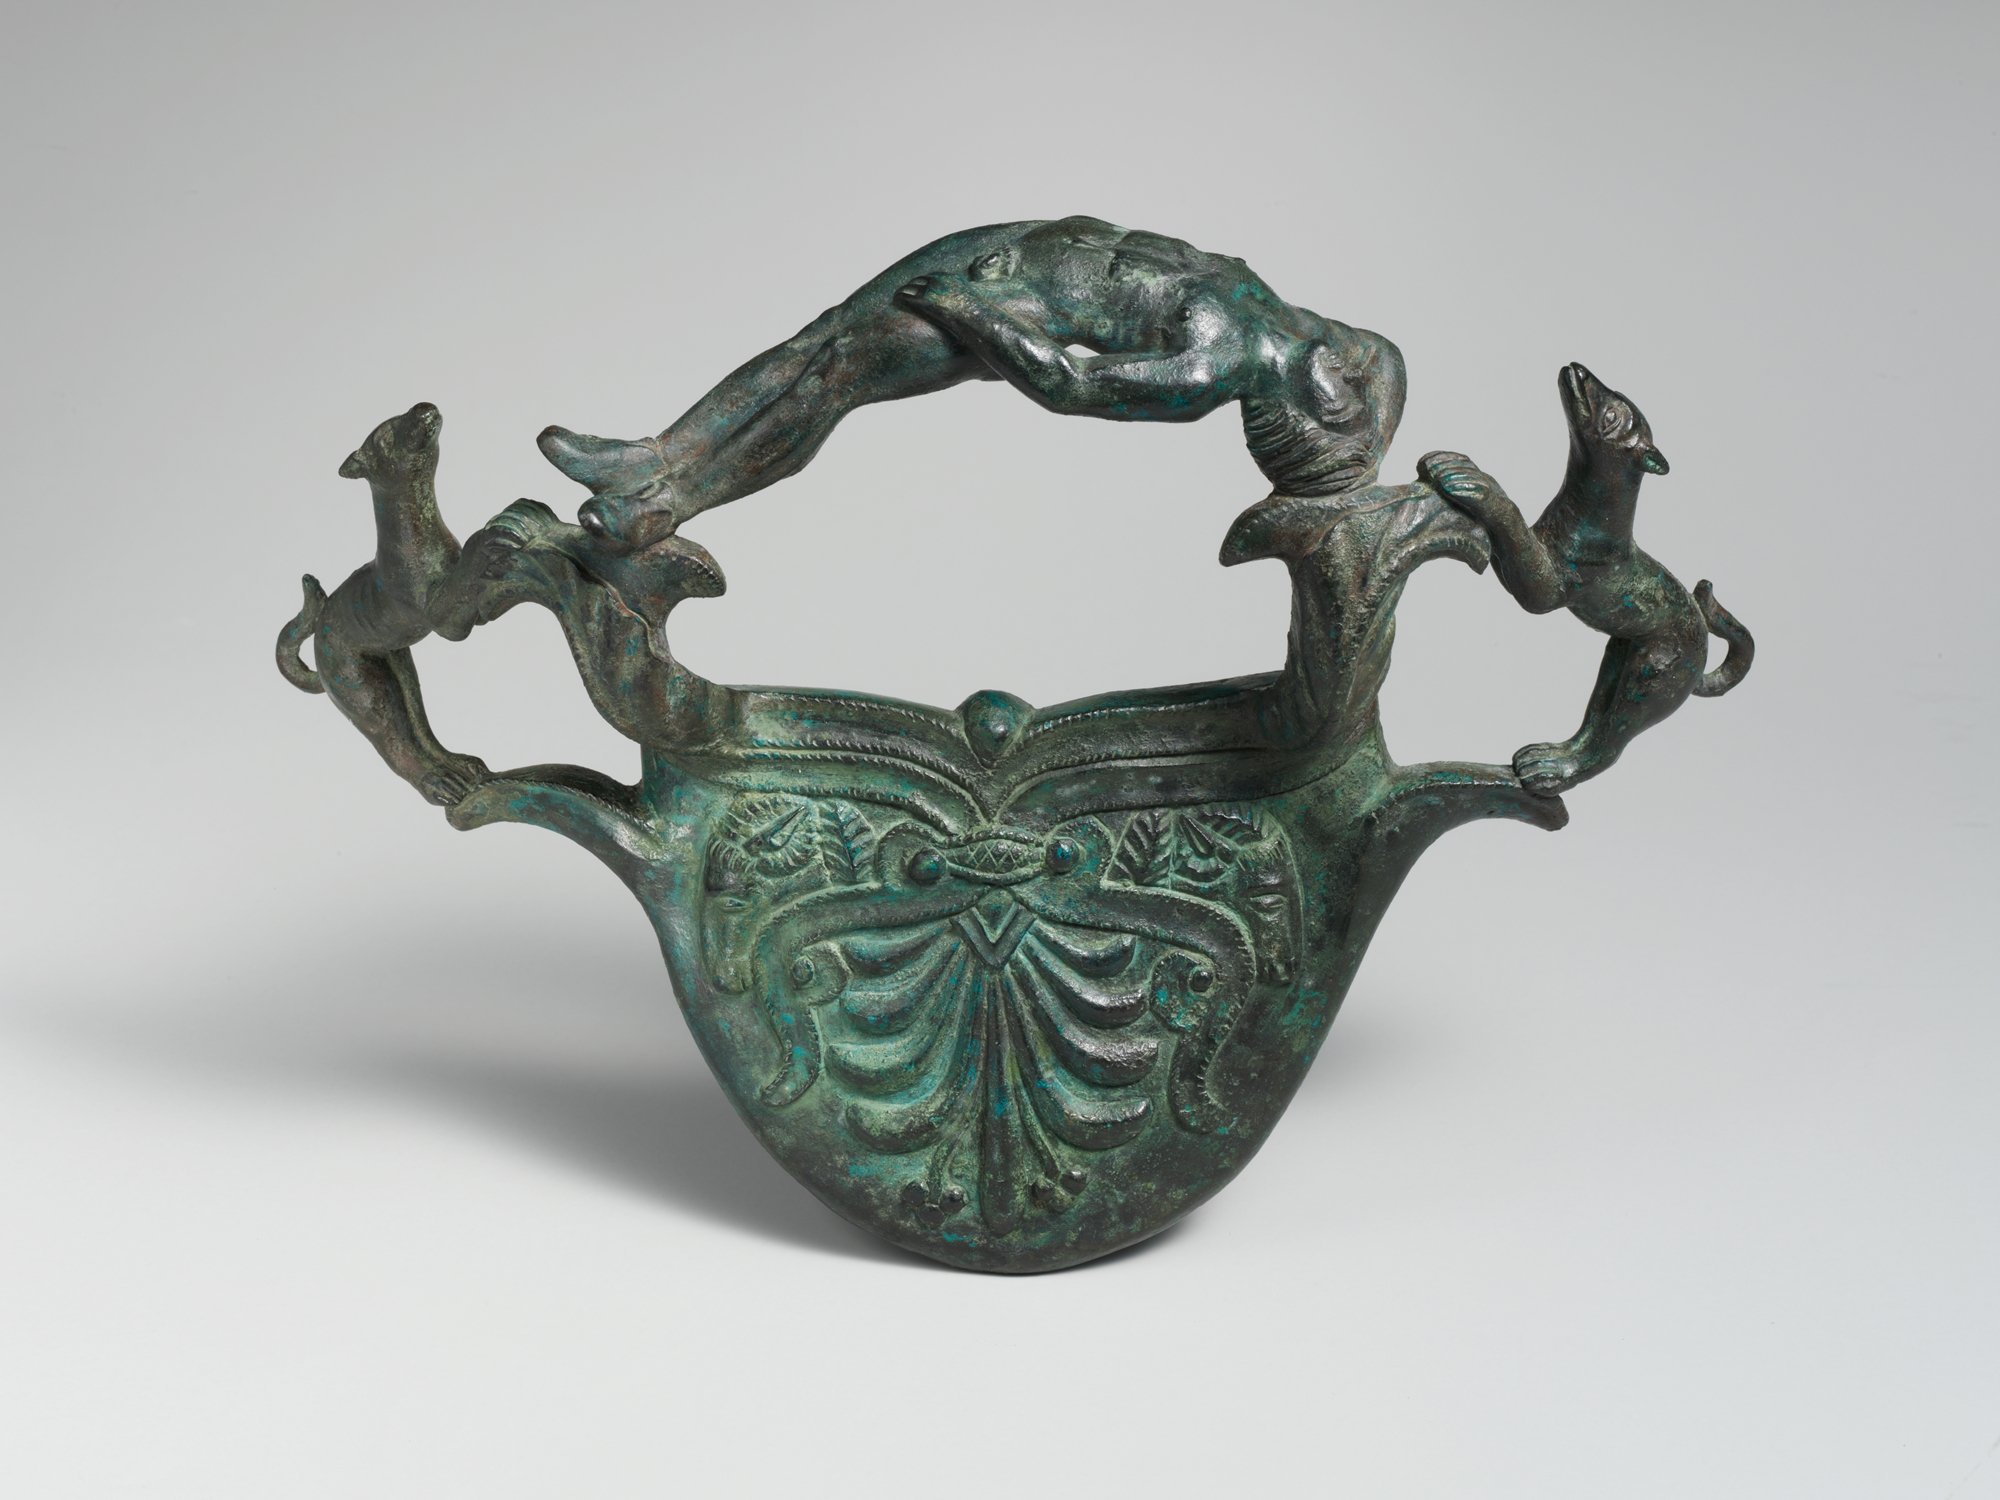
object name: handle of a cauldron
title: Bronze handle with dogs flanking a reclining youth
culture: etruscan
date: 400-301 BCE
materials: bronze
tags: boys,dogs